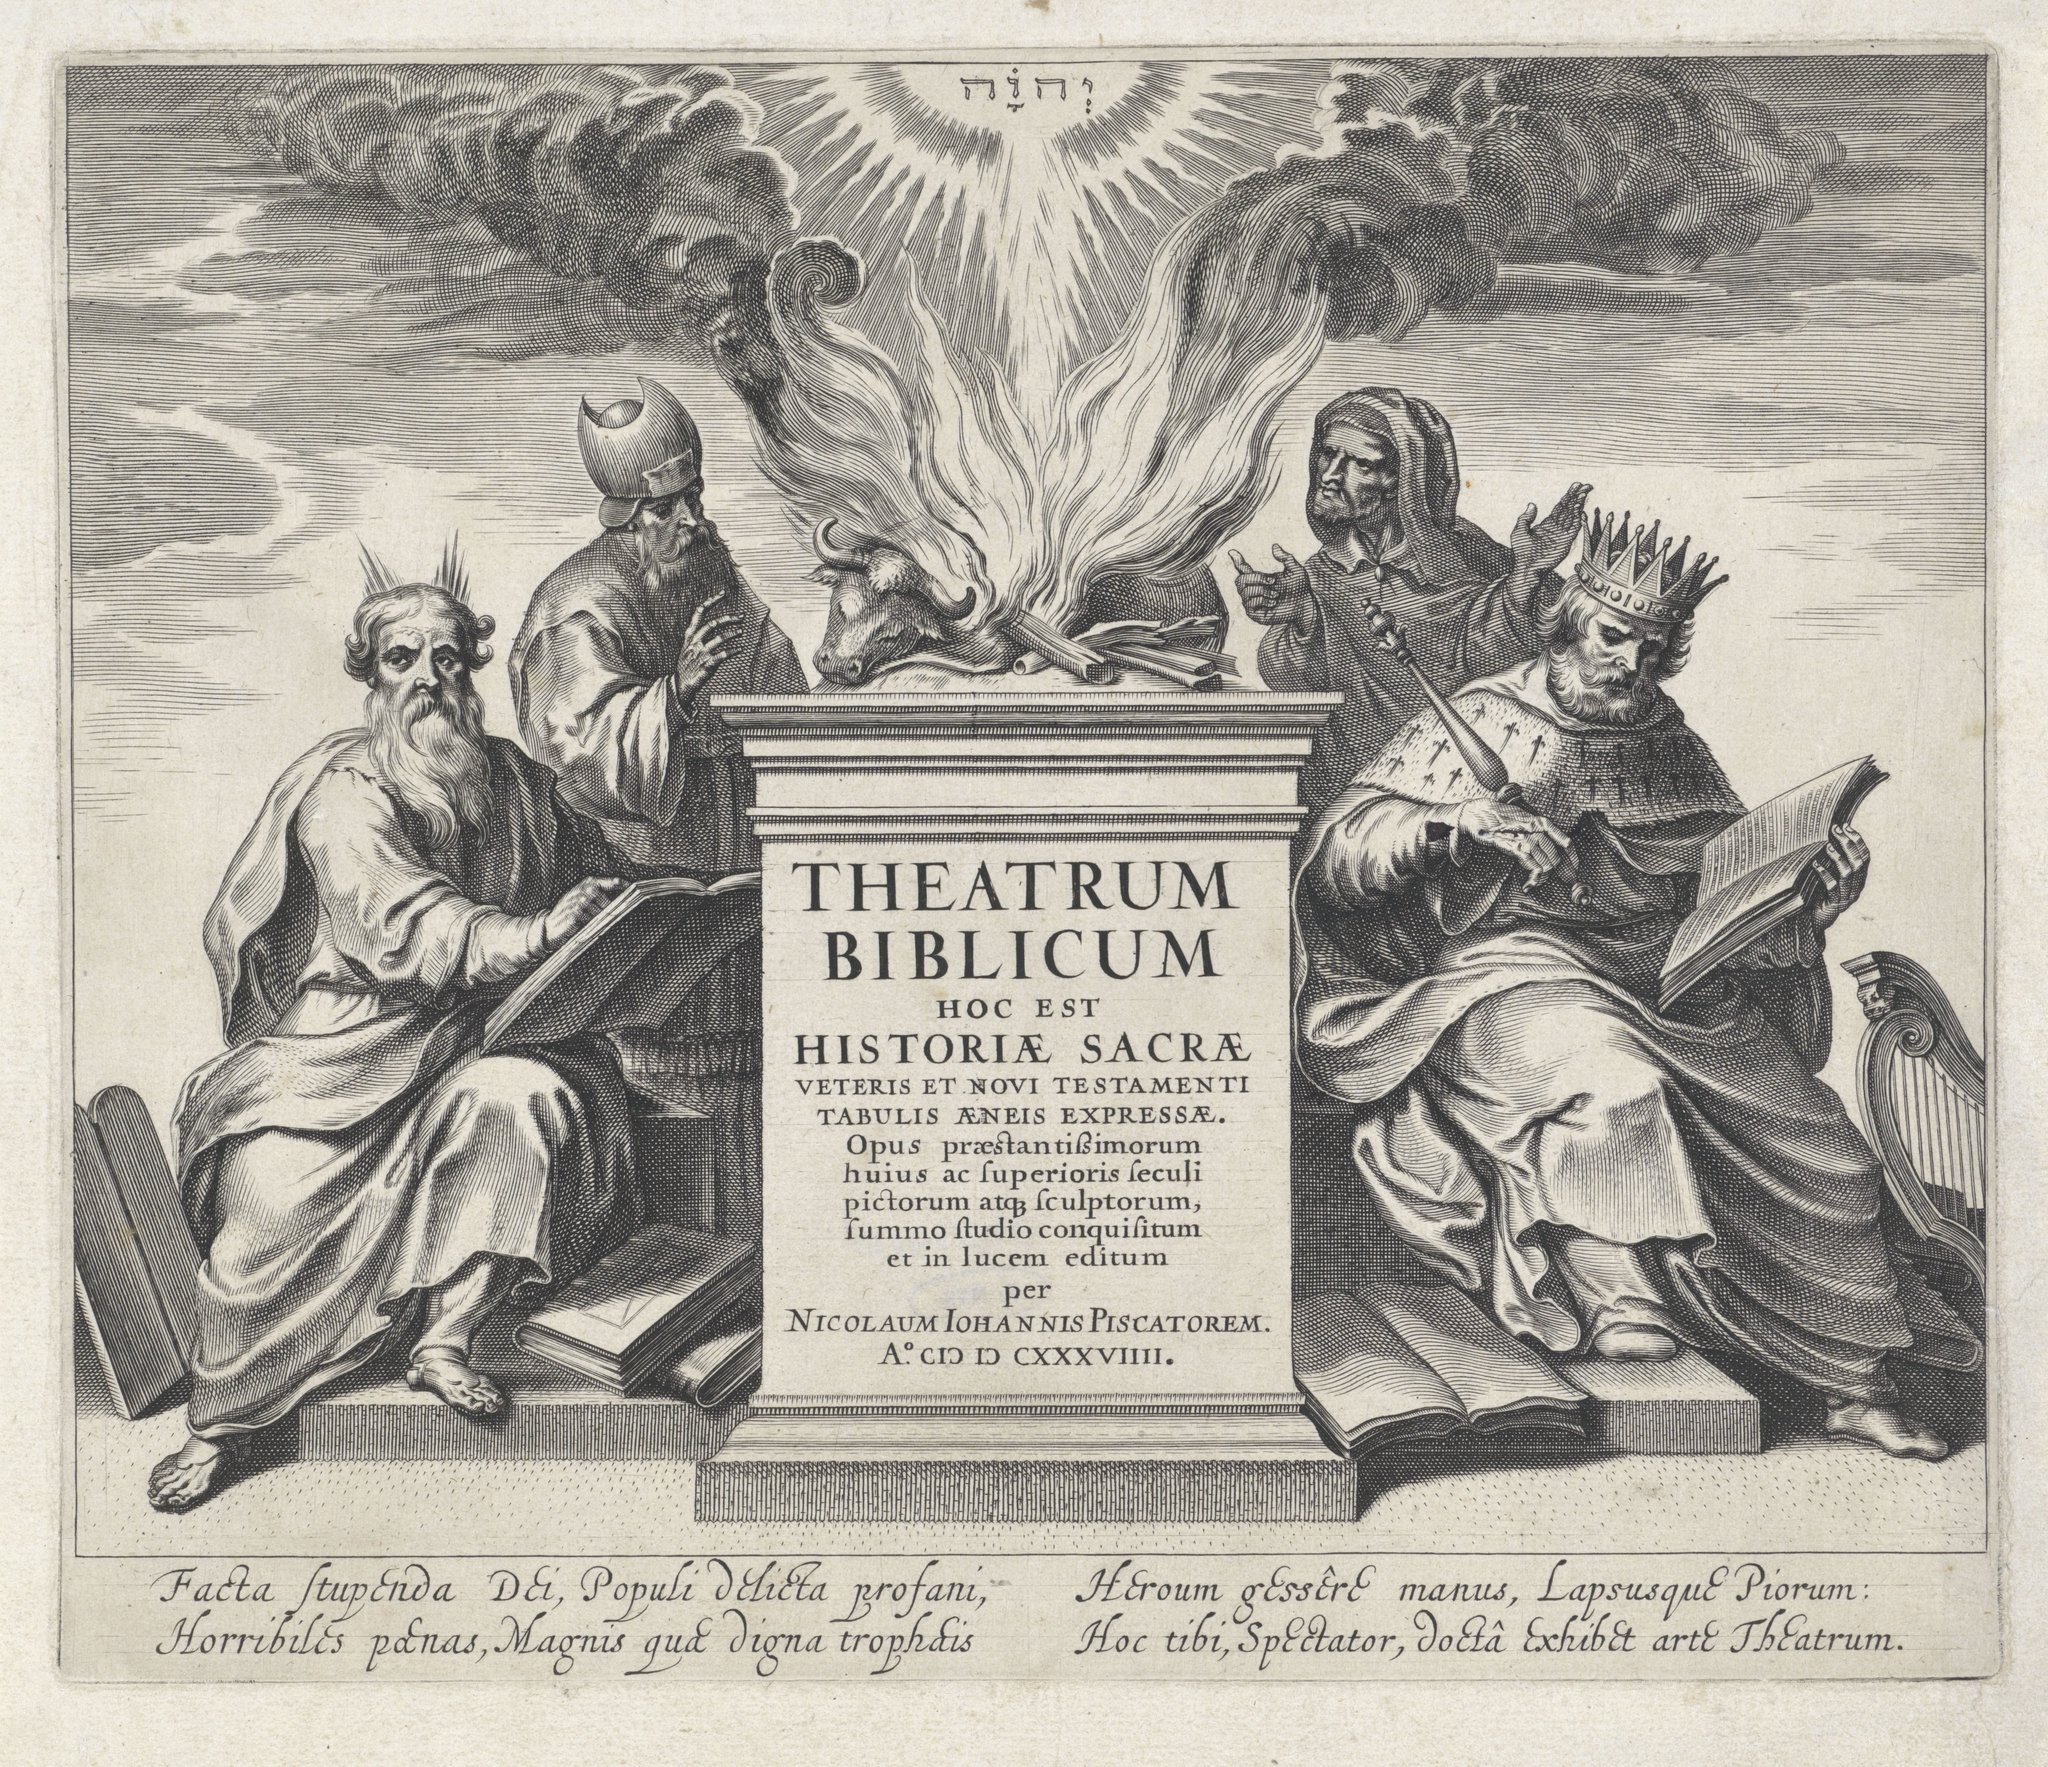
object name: print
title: Titelpagina voor: Theatrum biblicum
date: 1639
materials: paper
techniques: engraving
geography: amsterdam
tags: the ten commandments represented together, the book exodus: story of moses and aaron, story of david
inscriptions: collector's mark: Lugt 2228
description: Titelpagina voor: Theatrum biblicum : hoc est historiae sacrae veteris et novi testamenti tabulis aeneis expressae. Opus praesentatissimorum huius ac superioris seculi pictorum atque sculptorum, summo studio conquisitum et in lucem editum. Amsterdam: Nicolaas, Visscher, 1639.